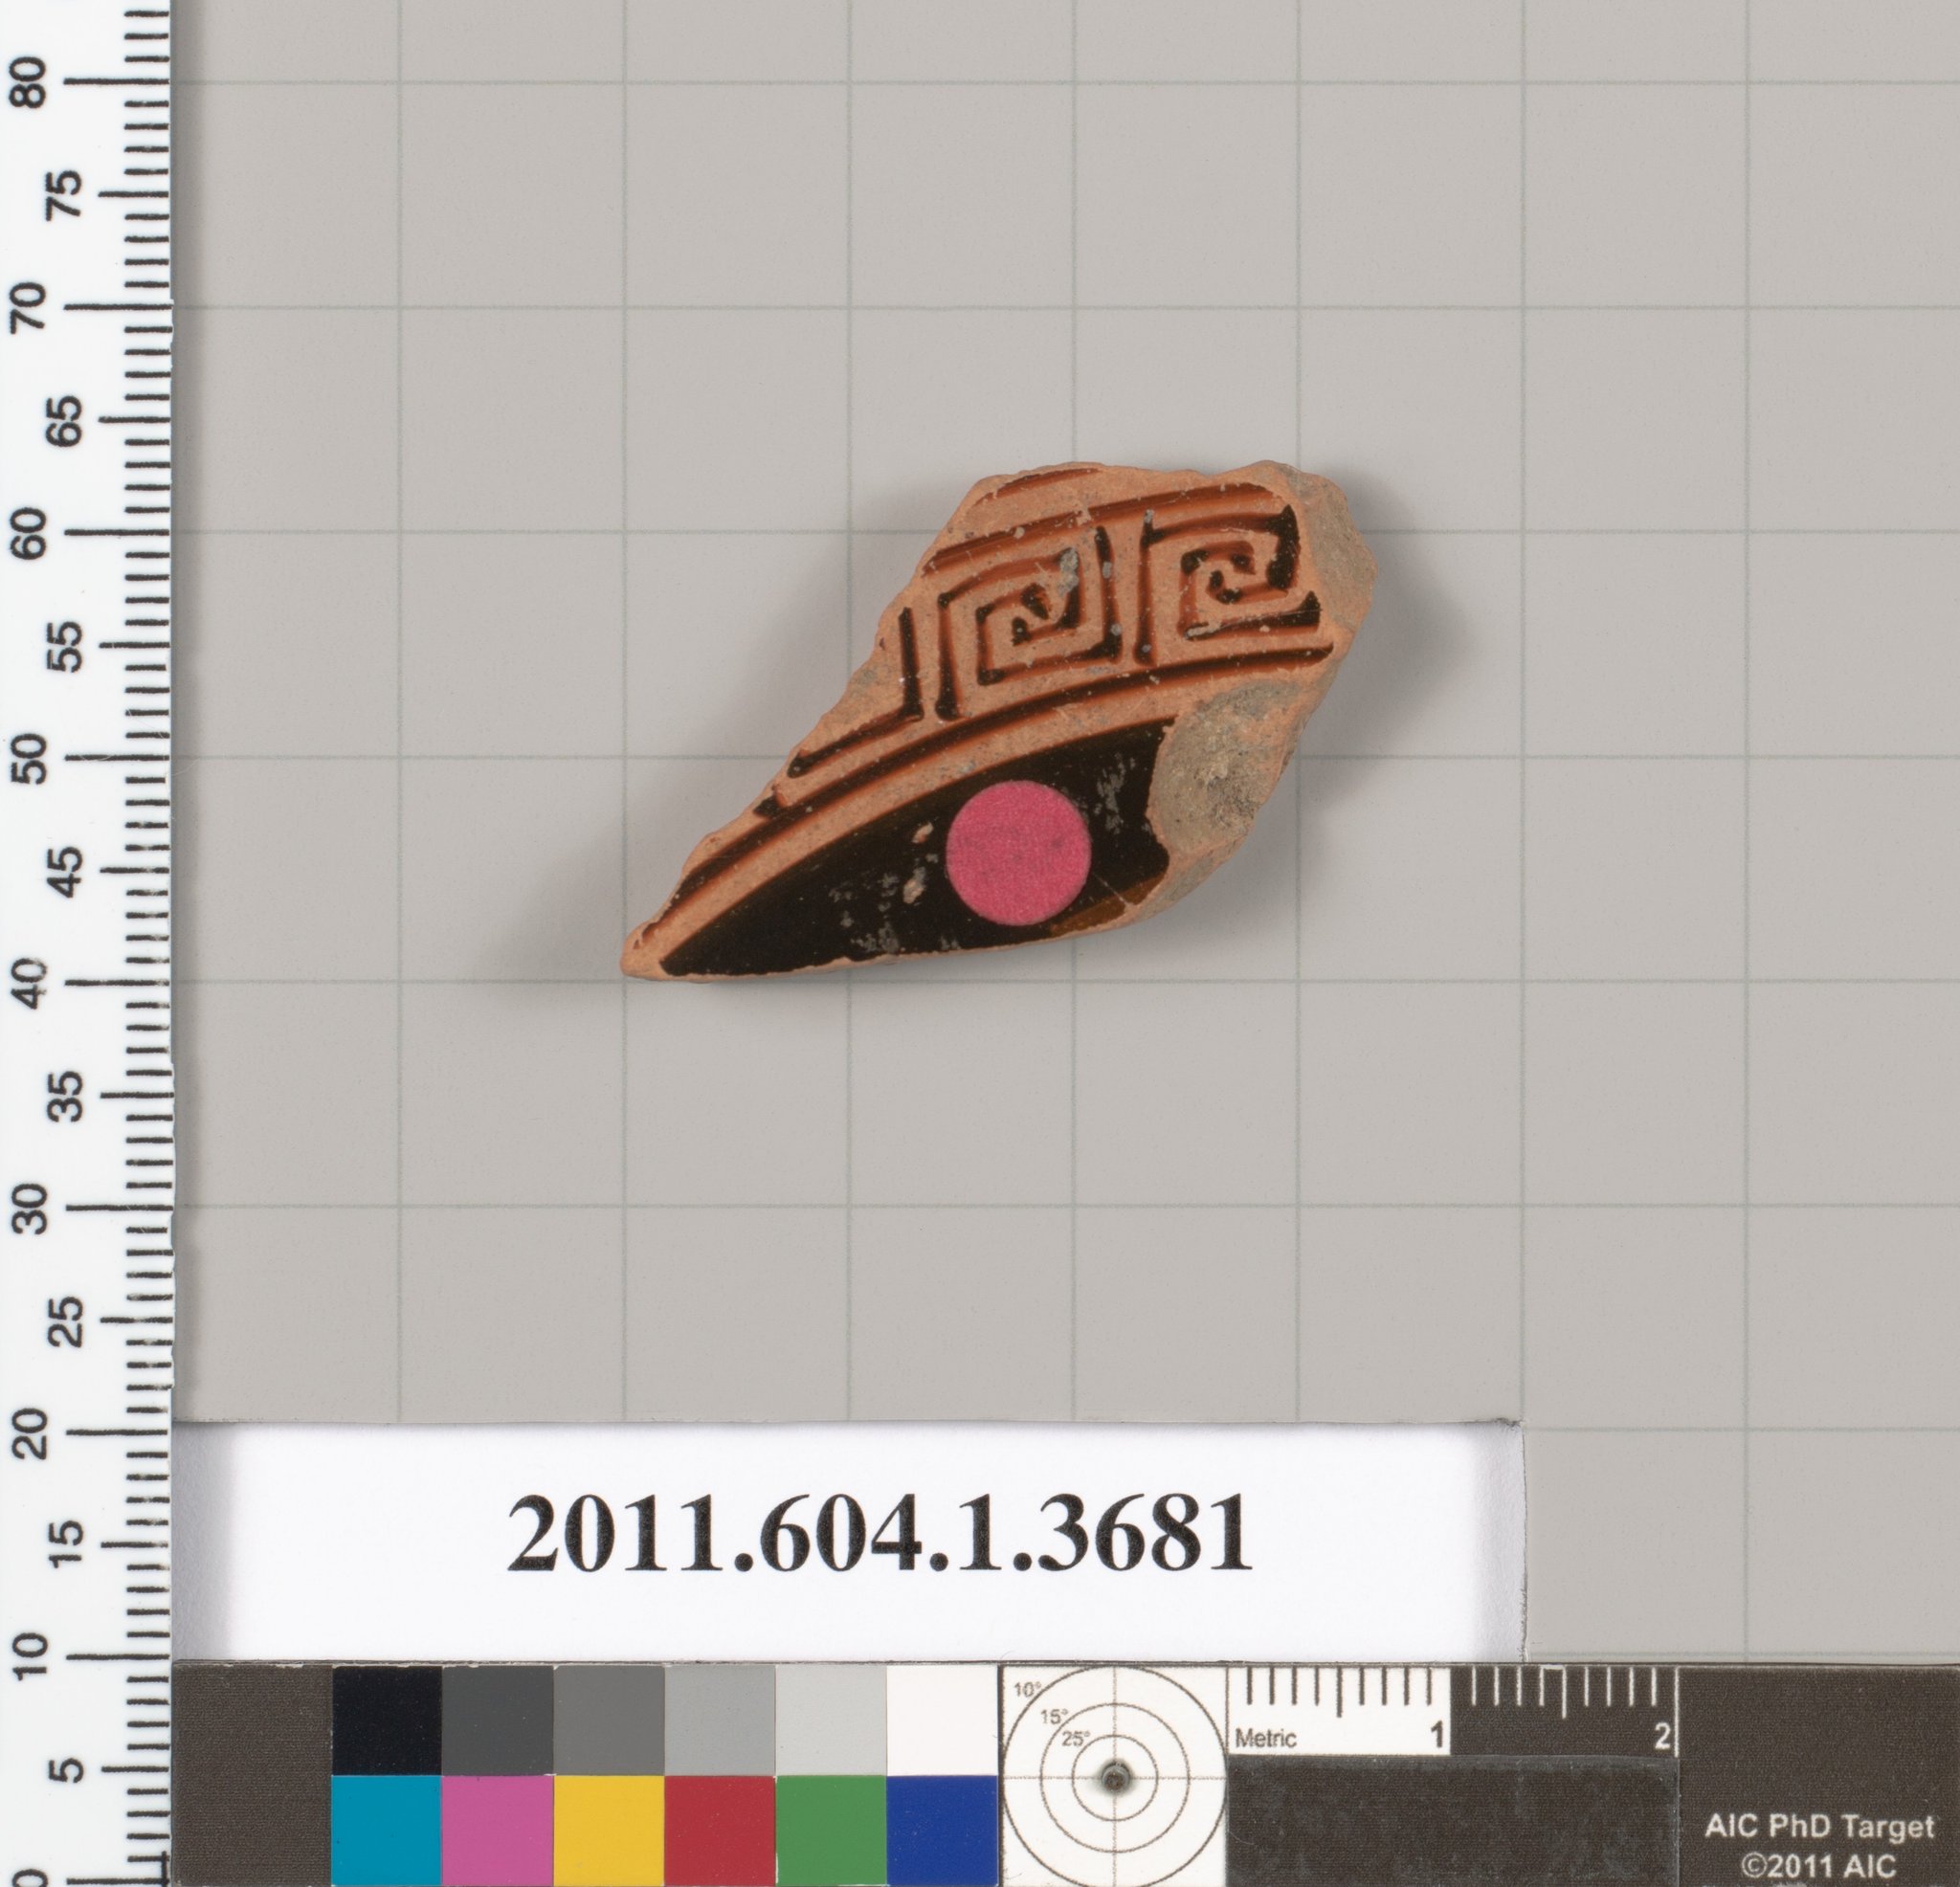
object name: kylix fragment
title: Terracotta fragment of a kylix (drinking cup)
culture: greek, attic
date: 475-451 BCE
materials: terracotta